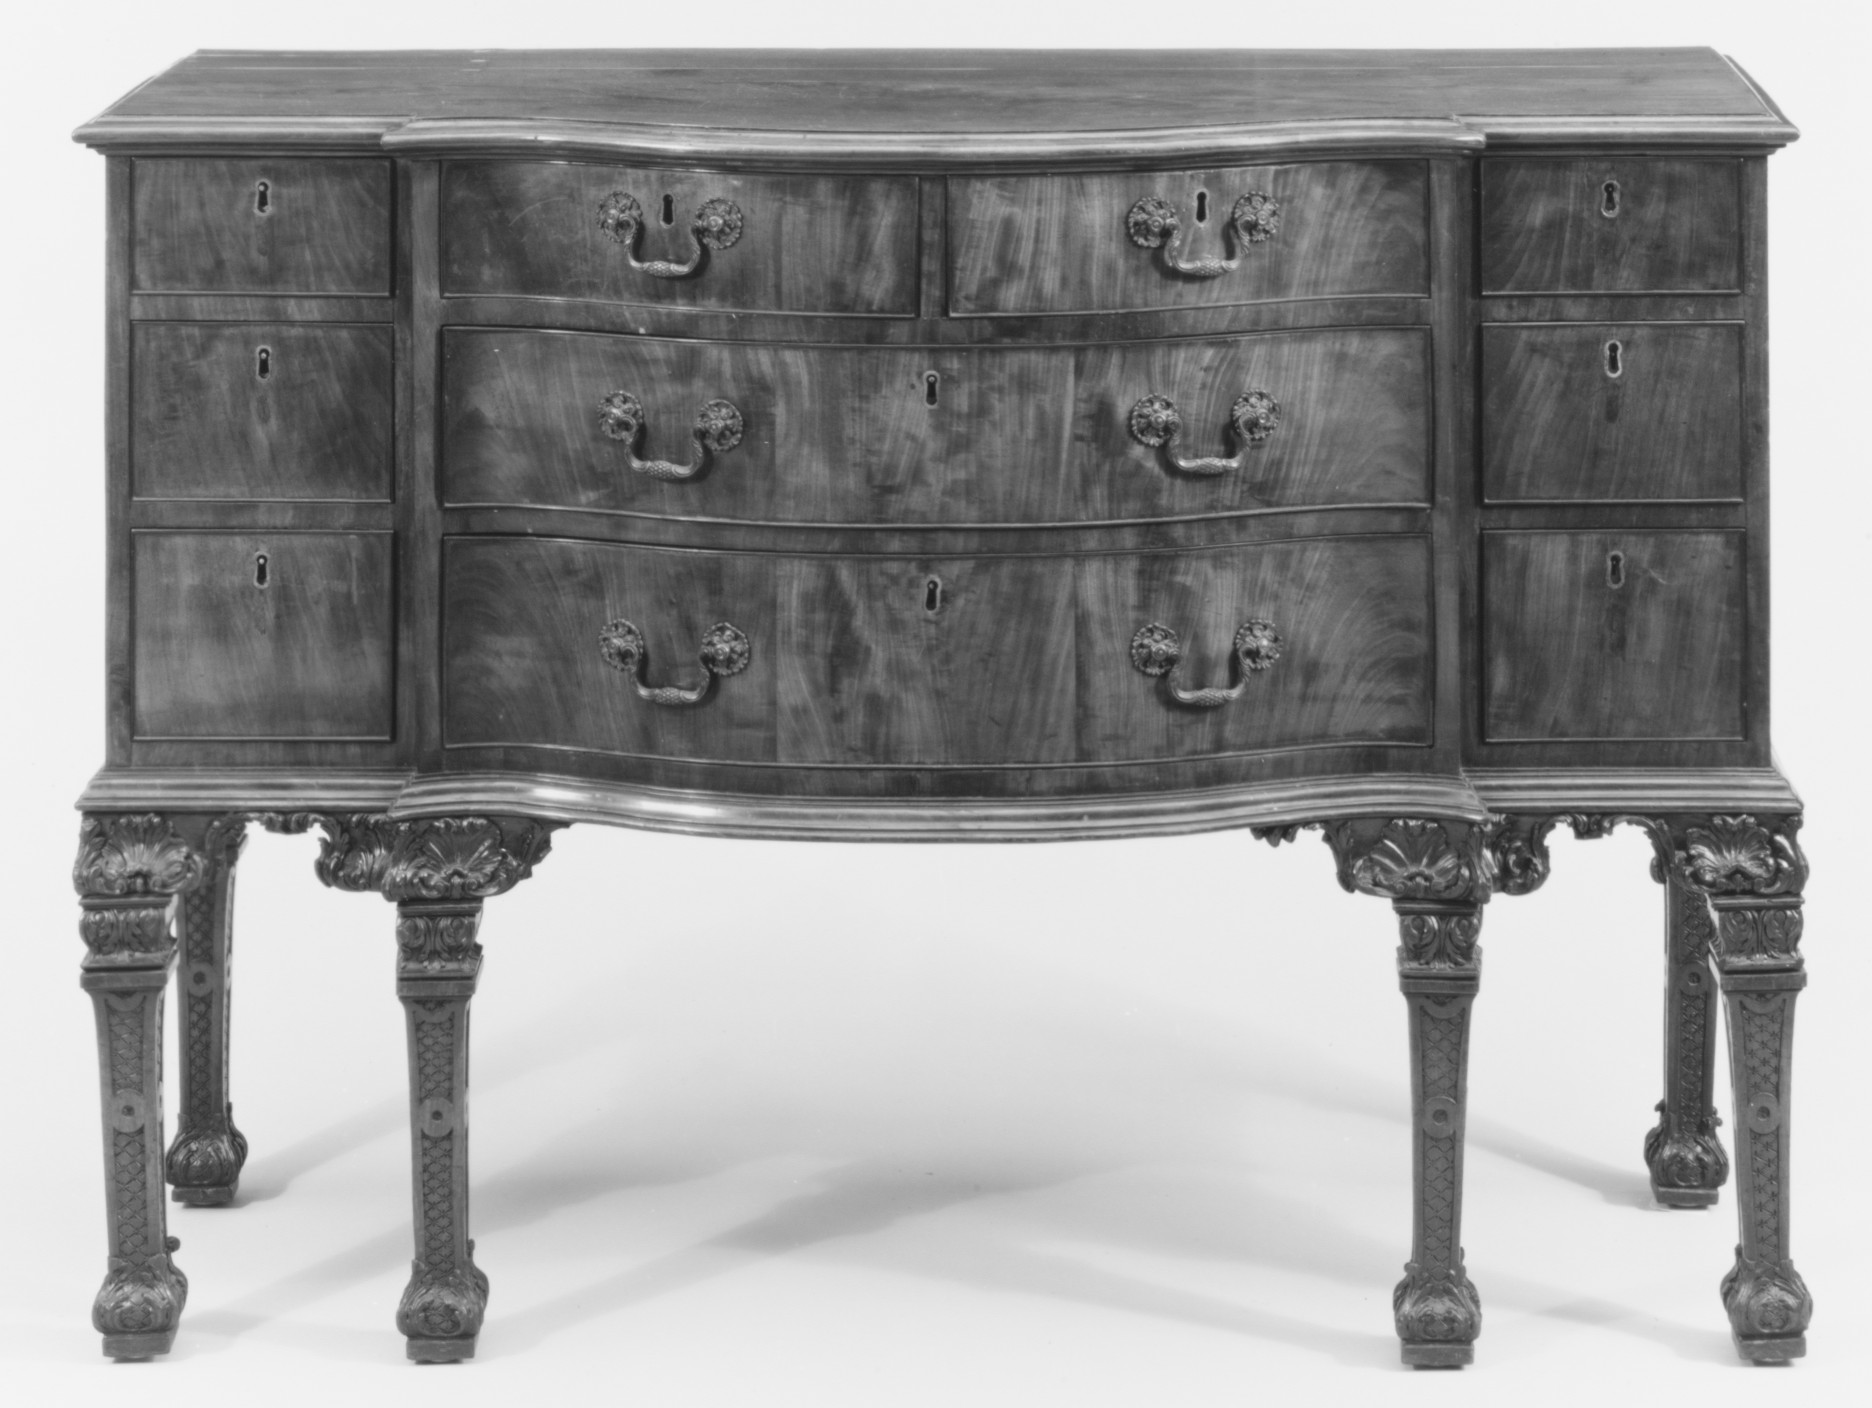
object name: commode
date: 1760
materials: brass, wood